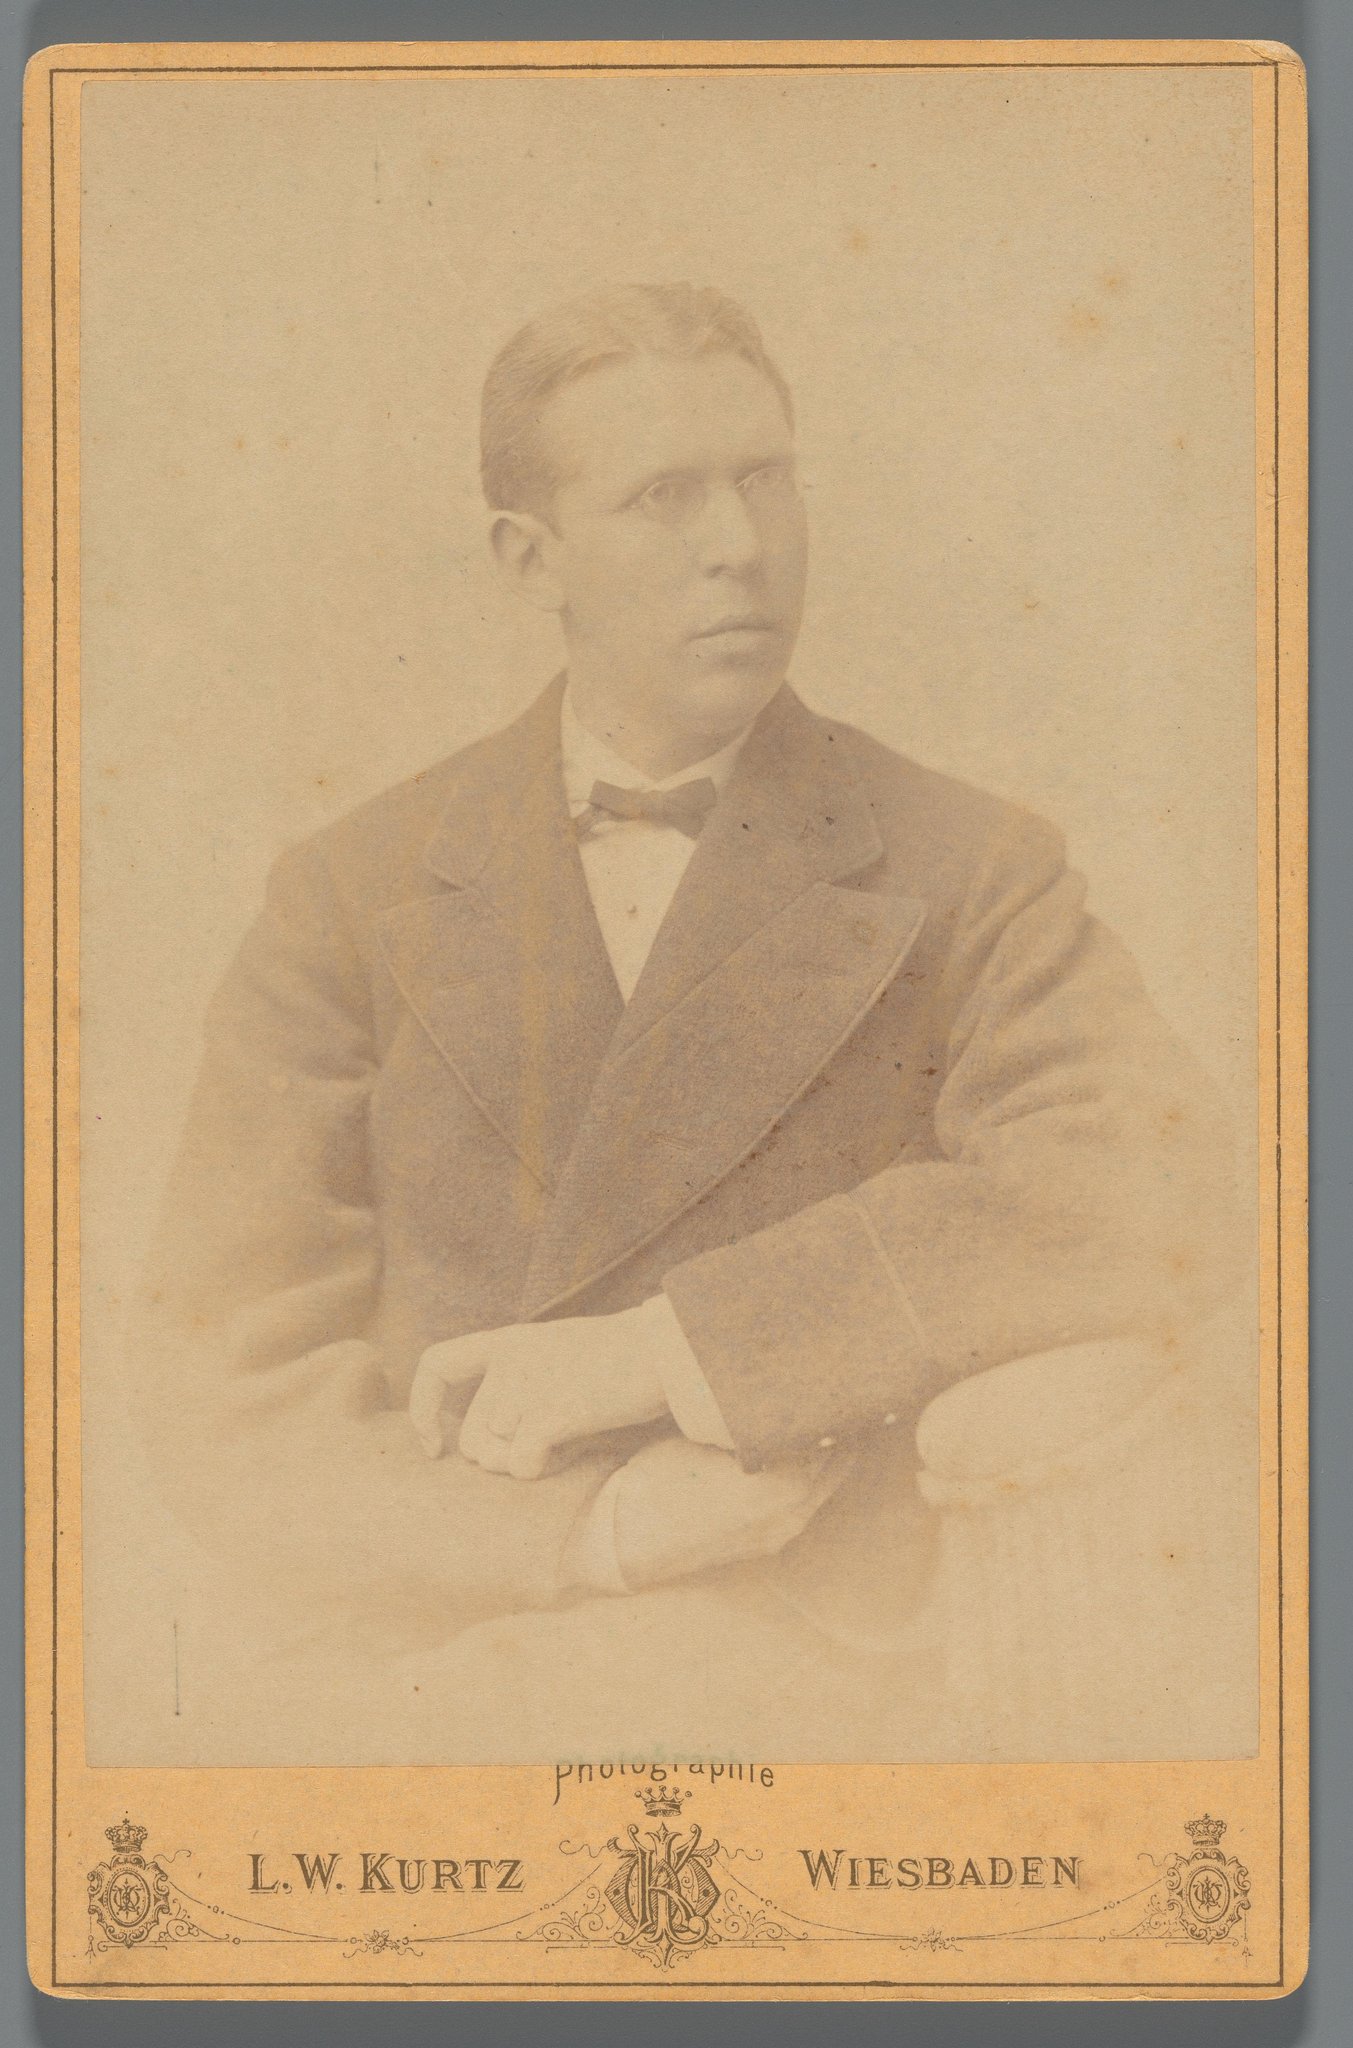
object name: cabinet photograph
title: Portret van Henricus Petrus Joannes van den Berg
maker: leonhard w. kurtz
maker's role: fotograaf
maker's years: 1849-1906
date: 1804-1877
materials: cardboard, photographic support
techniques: albumen print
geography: wiesbaden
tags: rotterdam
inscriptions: name: ‘L.W. KURTZ WIESBADEN’, name: ‘Voor Jet en ... / Gemaakt April 77.’